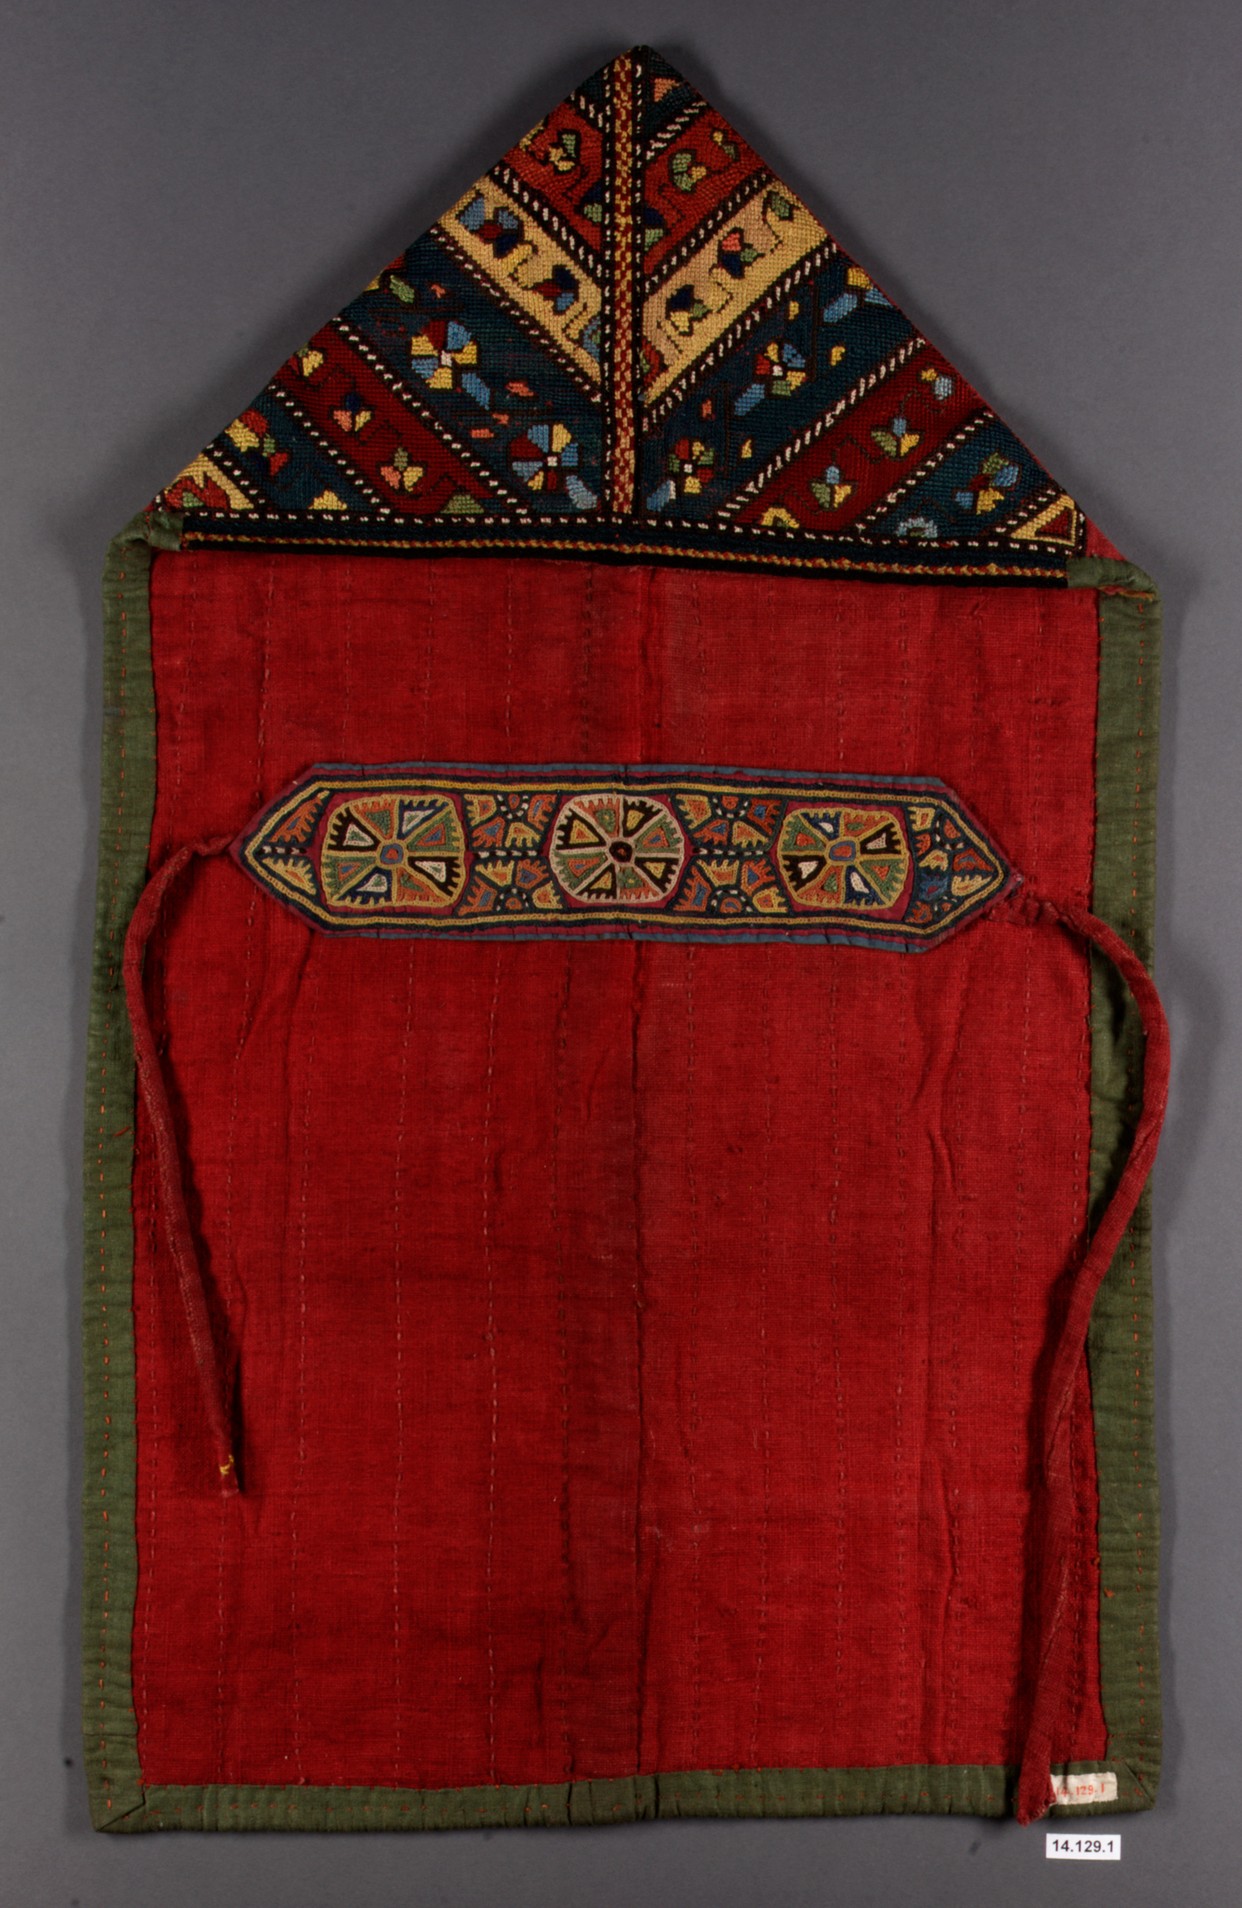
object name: headdress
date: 1701-1900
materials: linen, silk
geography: iran